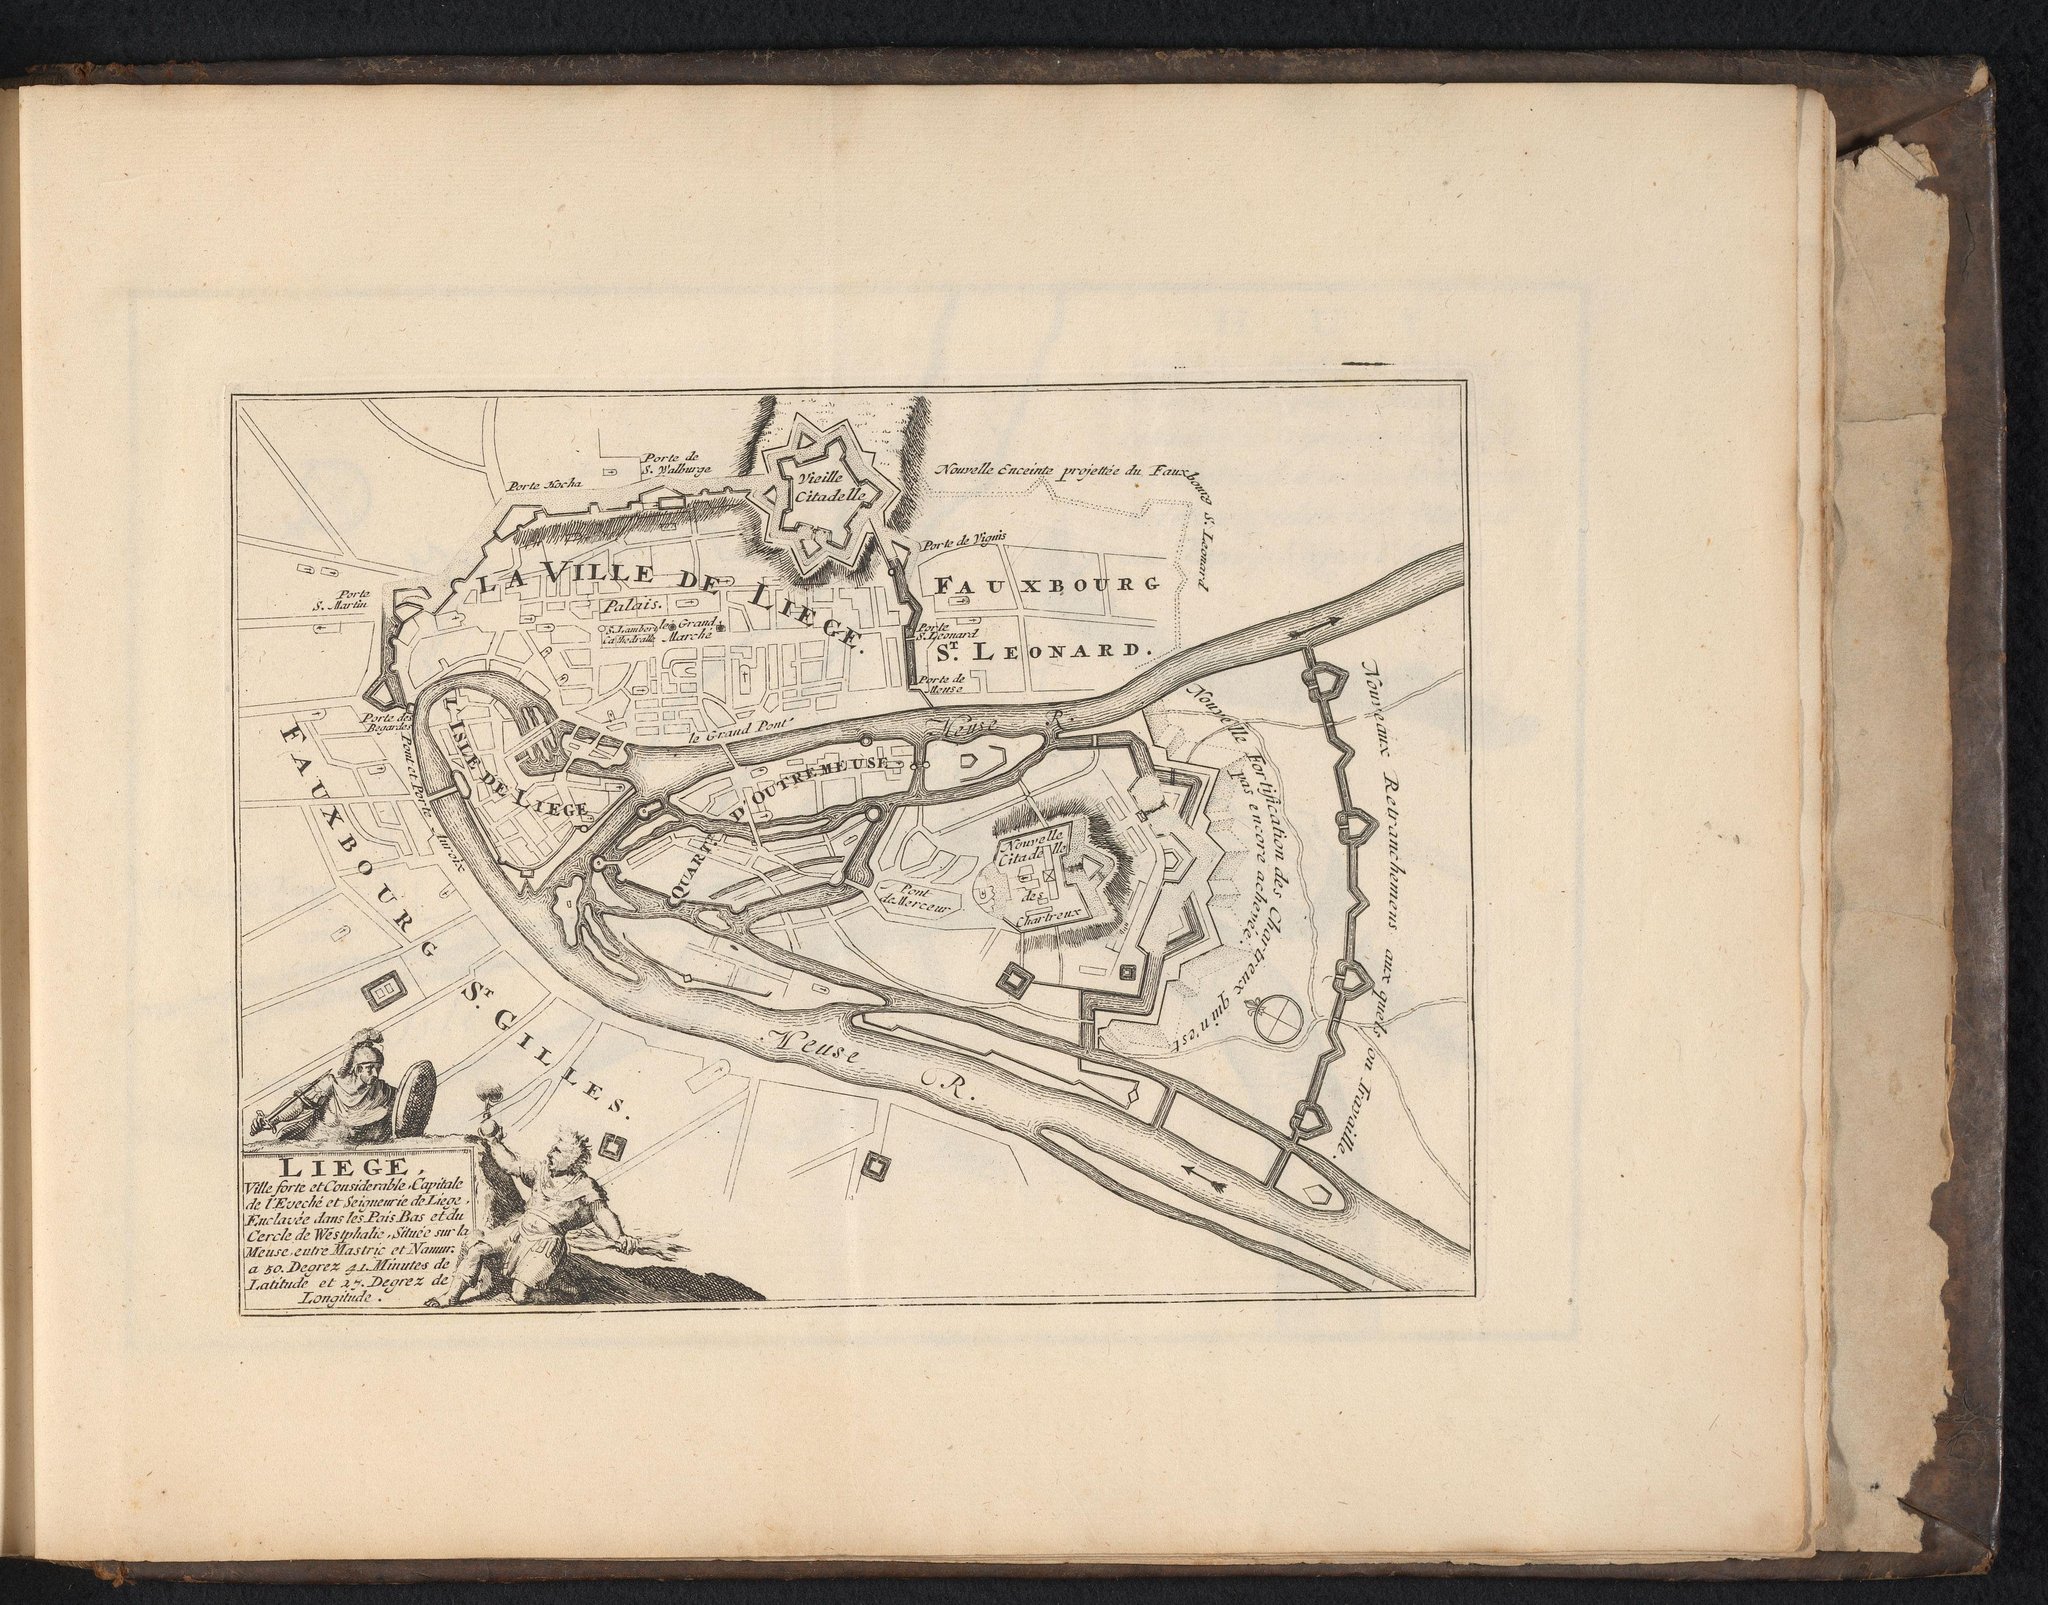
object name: area plan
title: Le theatre de la guerre, dans les Pays-Bas, ou representation des principales villes qui sont en Flandre, Hainaut, Brabant, et c. : avec leurs fortifications : dessignées par les meilleurs ingenieurs, particulierement celles (...) dont les plans ont esté levez par M. de Vauban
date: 1693-1696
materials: paper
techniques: etching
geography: paris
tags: fortress, maps of cities, liège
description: Plattegrond van de versterkingen om de stad Luik. Onderdeel van het tweede van twee delen van het prentwerk: Le Theatre de la Guerre, dans les Pays-Bas, waarvan het titelblad uitgegeven is in 1696. Het prentwerk bestaat in totaal (beide delen) uit 52 platen met plannen (afkomstig van Sébastien Le Prestre, Seigneur de Vauban) van vermaarde sterke steden en vestingen in de Negenjarige Oorlog in de Nederlanden. Identiek aan de plaat die voorkomt in: Les forces de l'Europe, uitgegeven tussen 1693-1697. Titel en opschriften in het Frans.